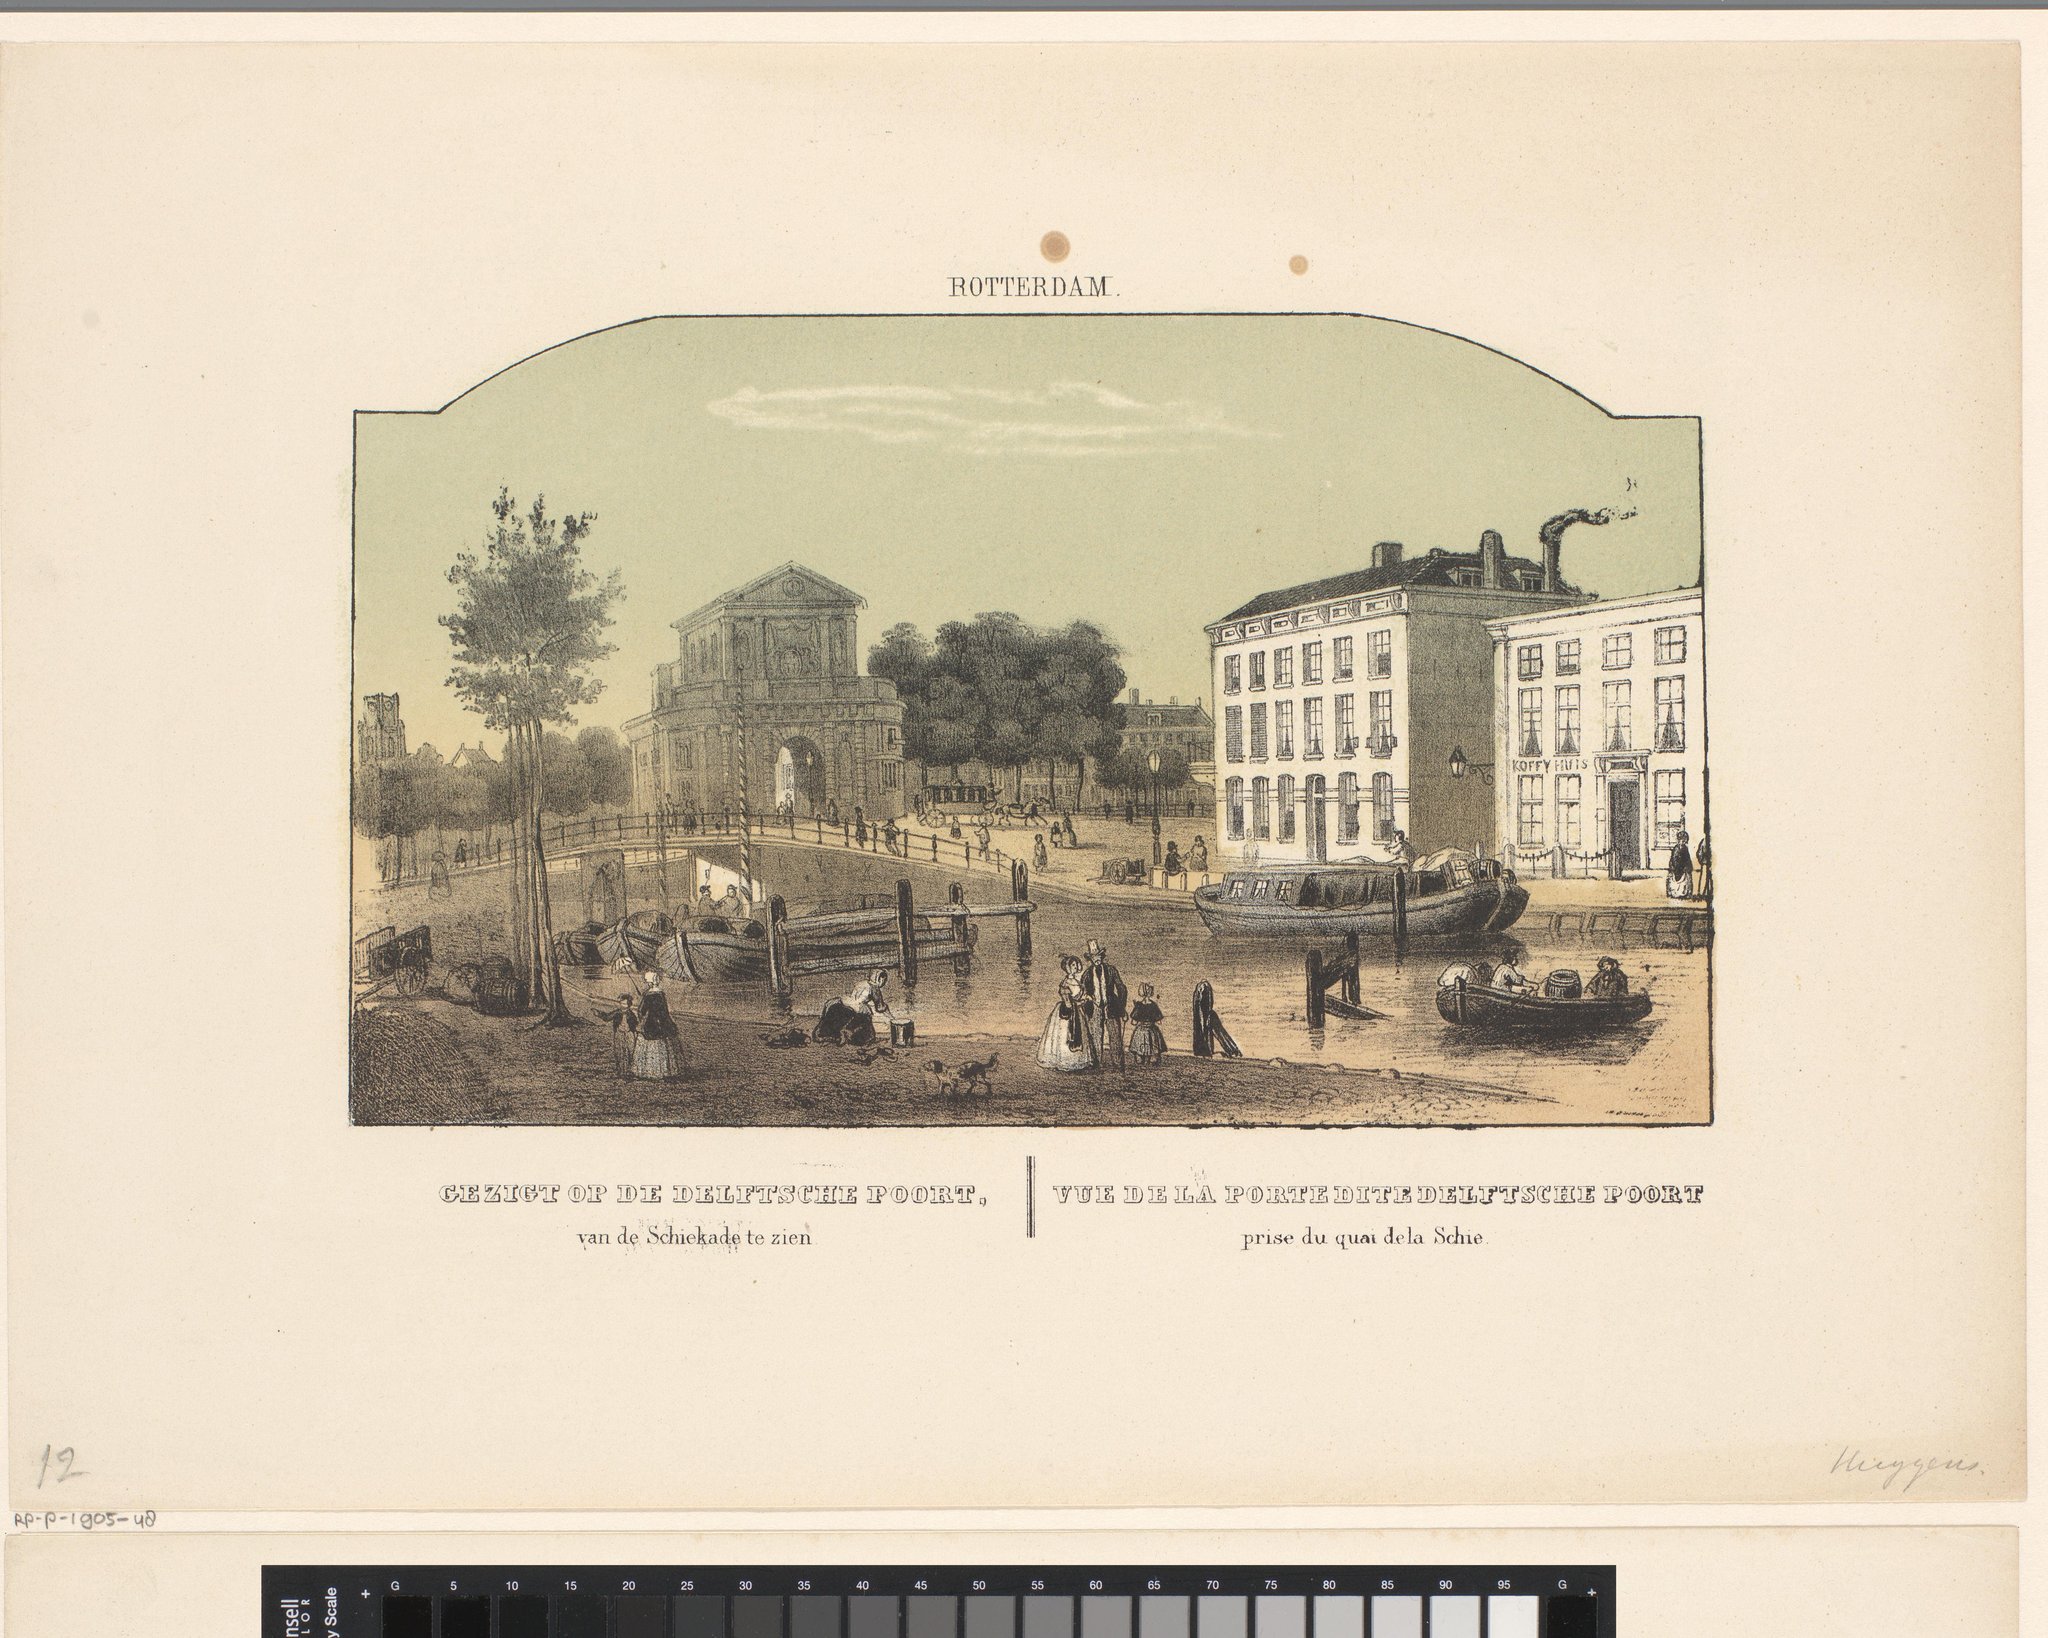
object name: print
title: Gezicht op de Delftsche Poort in Rotterdam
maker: frederik lodewijk huygens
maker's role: draughtsman, print maker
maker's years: 1802-1887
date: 1812-1887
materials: paper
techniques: iris print, lithograph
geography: netherlands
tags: city-gate, city-view, and landscape with man-made constructions (+ city(-scape) with figures, staffage), rotterdam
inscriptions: collector's mark: Lugt 2228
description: Maakte deel uit van een serie over Rotterdam, zie RP-P-1905-46 t/m RP-P-1905-53. Nummer RP-P-1905-46 hiervan is gesigneerd.